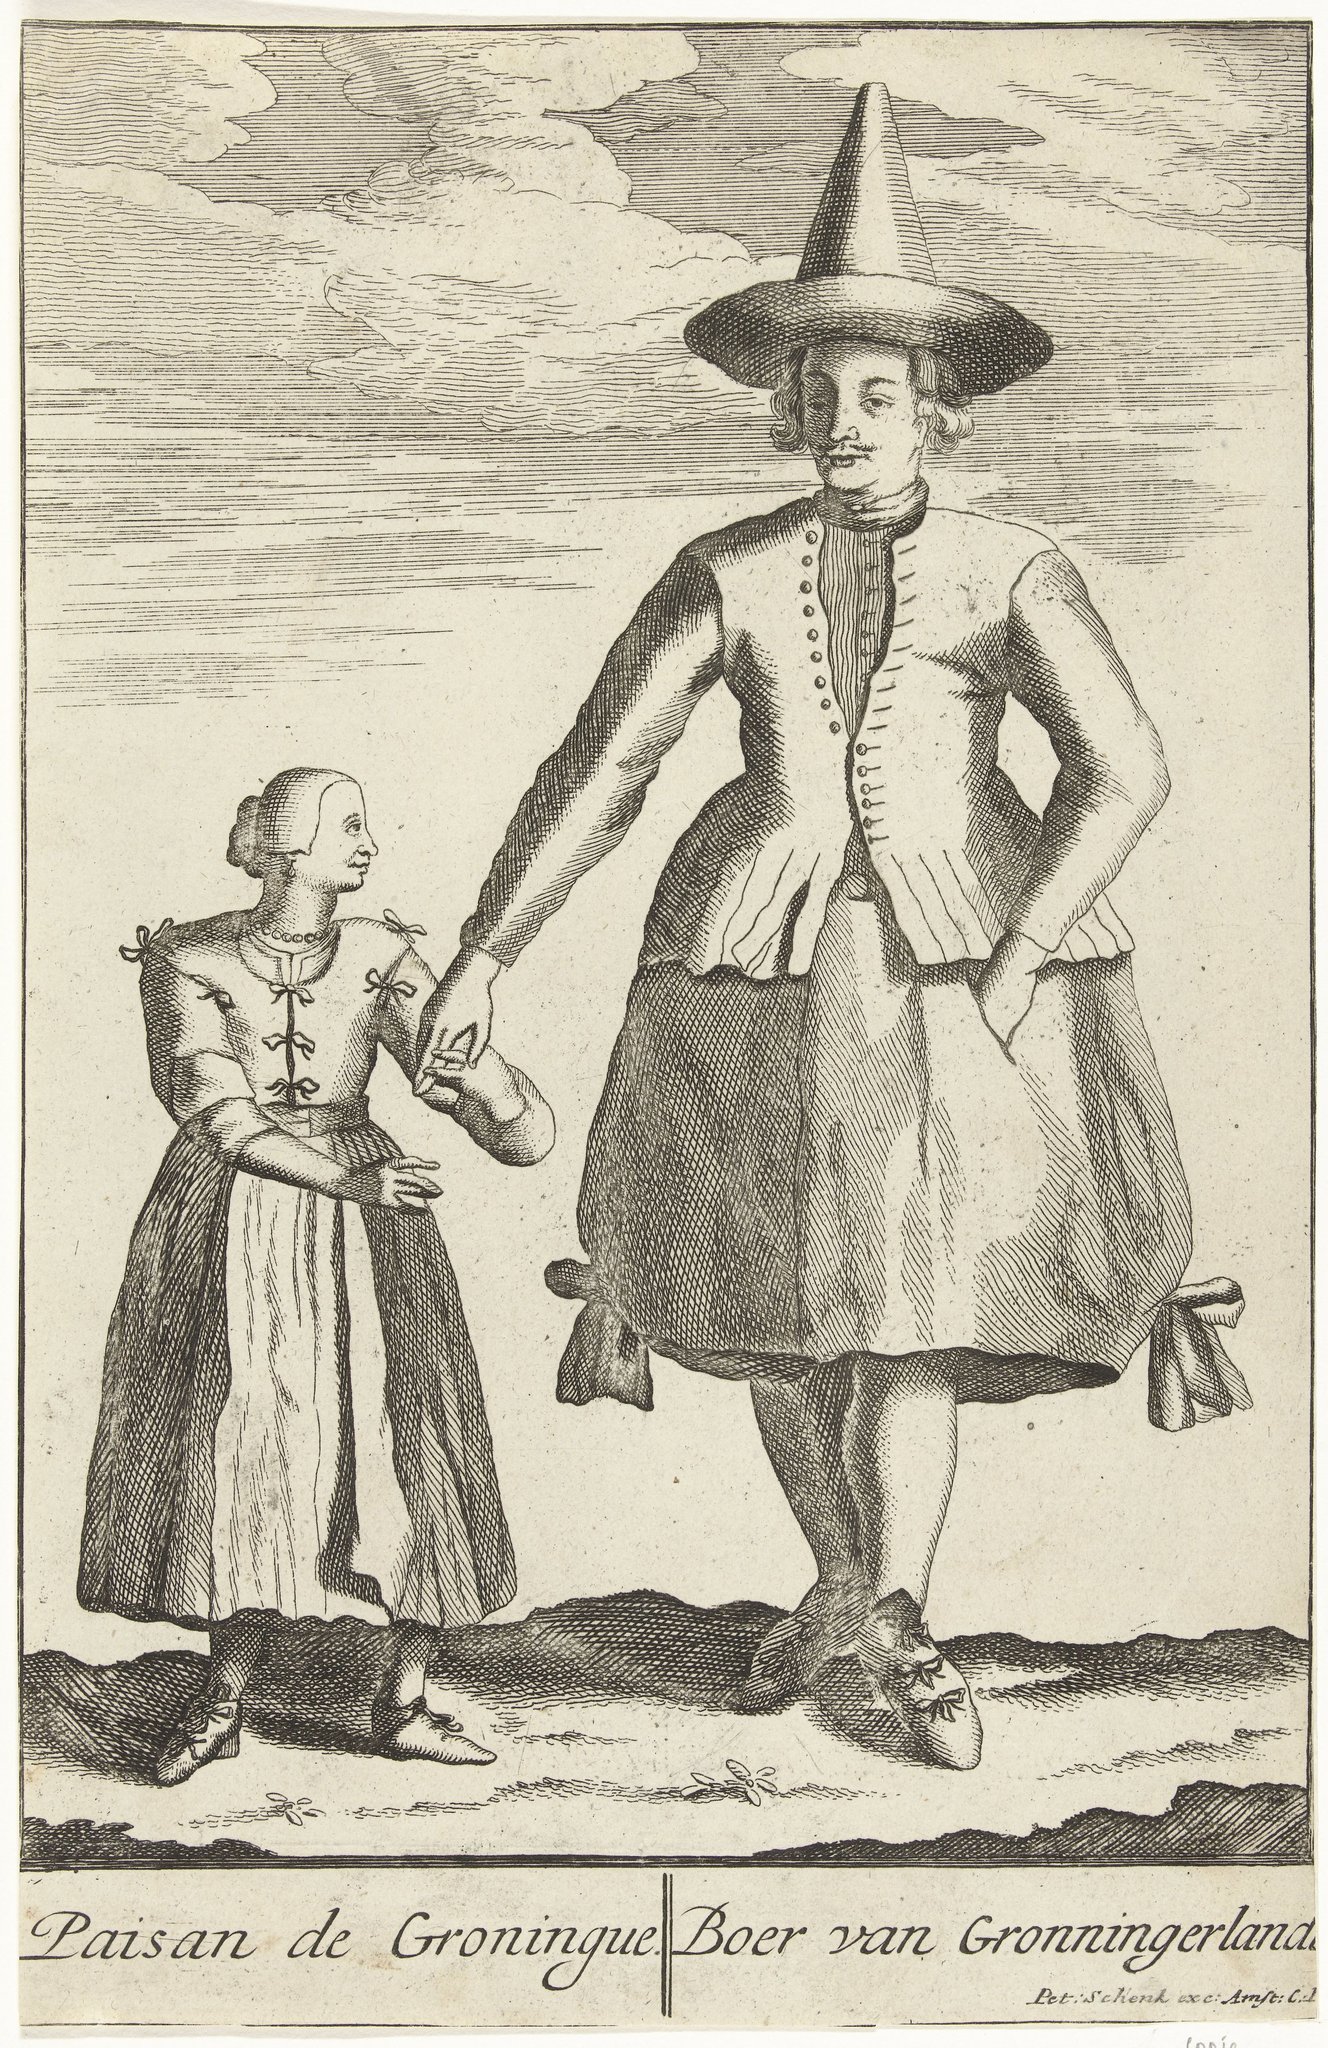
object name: print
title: Paisan de Groningue / Boer van Groningerlandt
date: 1689-1713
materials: paper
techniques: engraving, etching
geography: amsterdam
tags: head-gear, farmers, folk costume, regional costume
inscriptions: collector's mark: Lugt 2228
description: Een boer uit Groningen met zijn dochter. De boer draagt een puntige hoed en een bollende rok, het meisje draagt een vestje met strikjes. Prent uit een serie prenten naar Pieter van den Berge met dorpelingen die klederdrachten dragen.